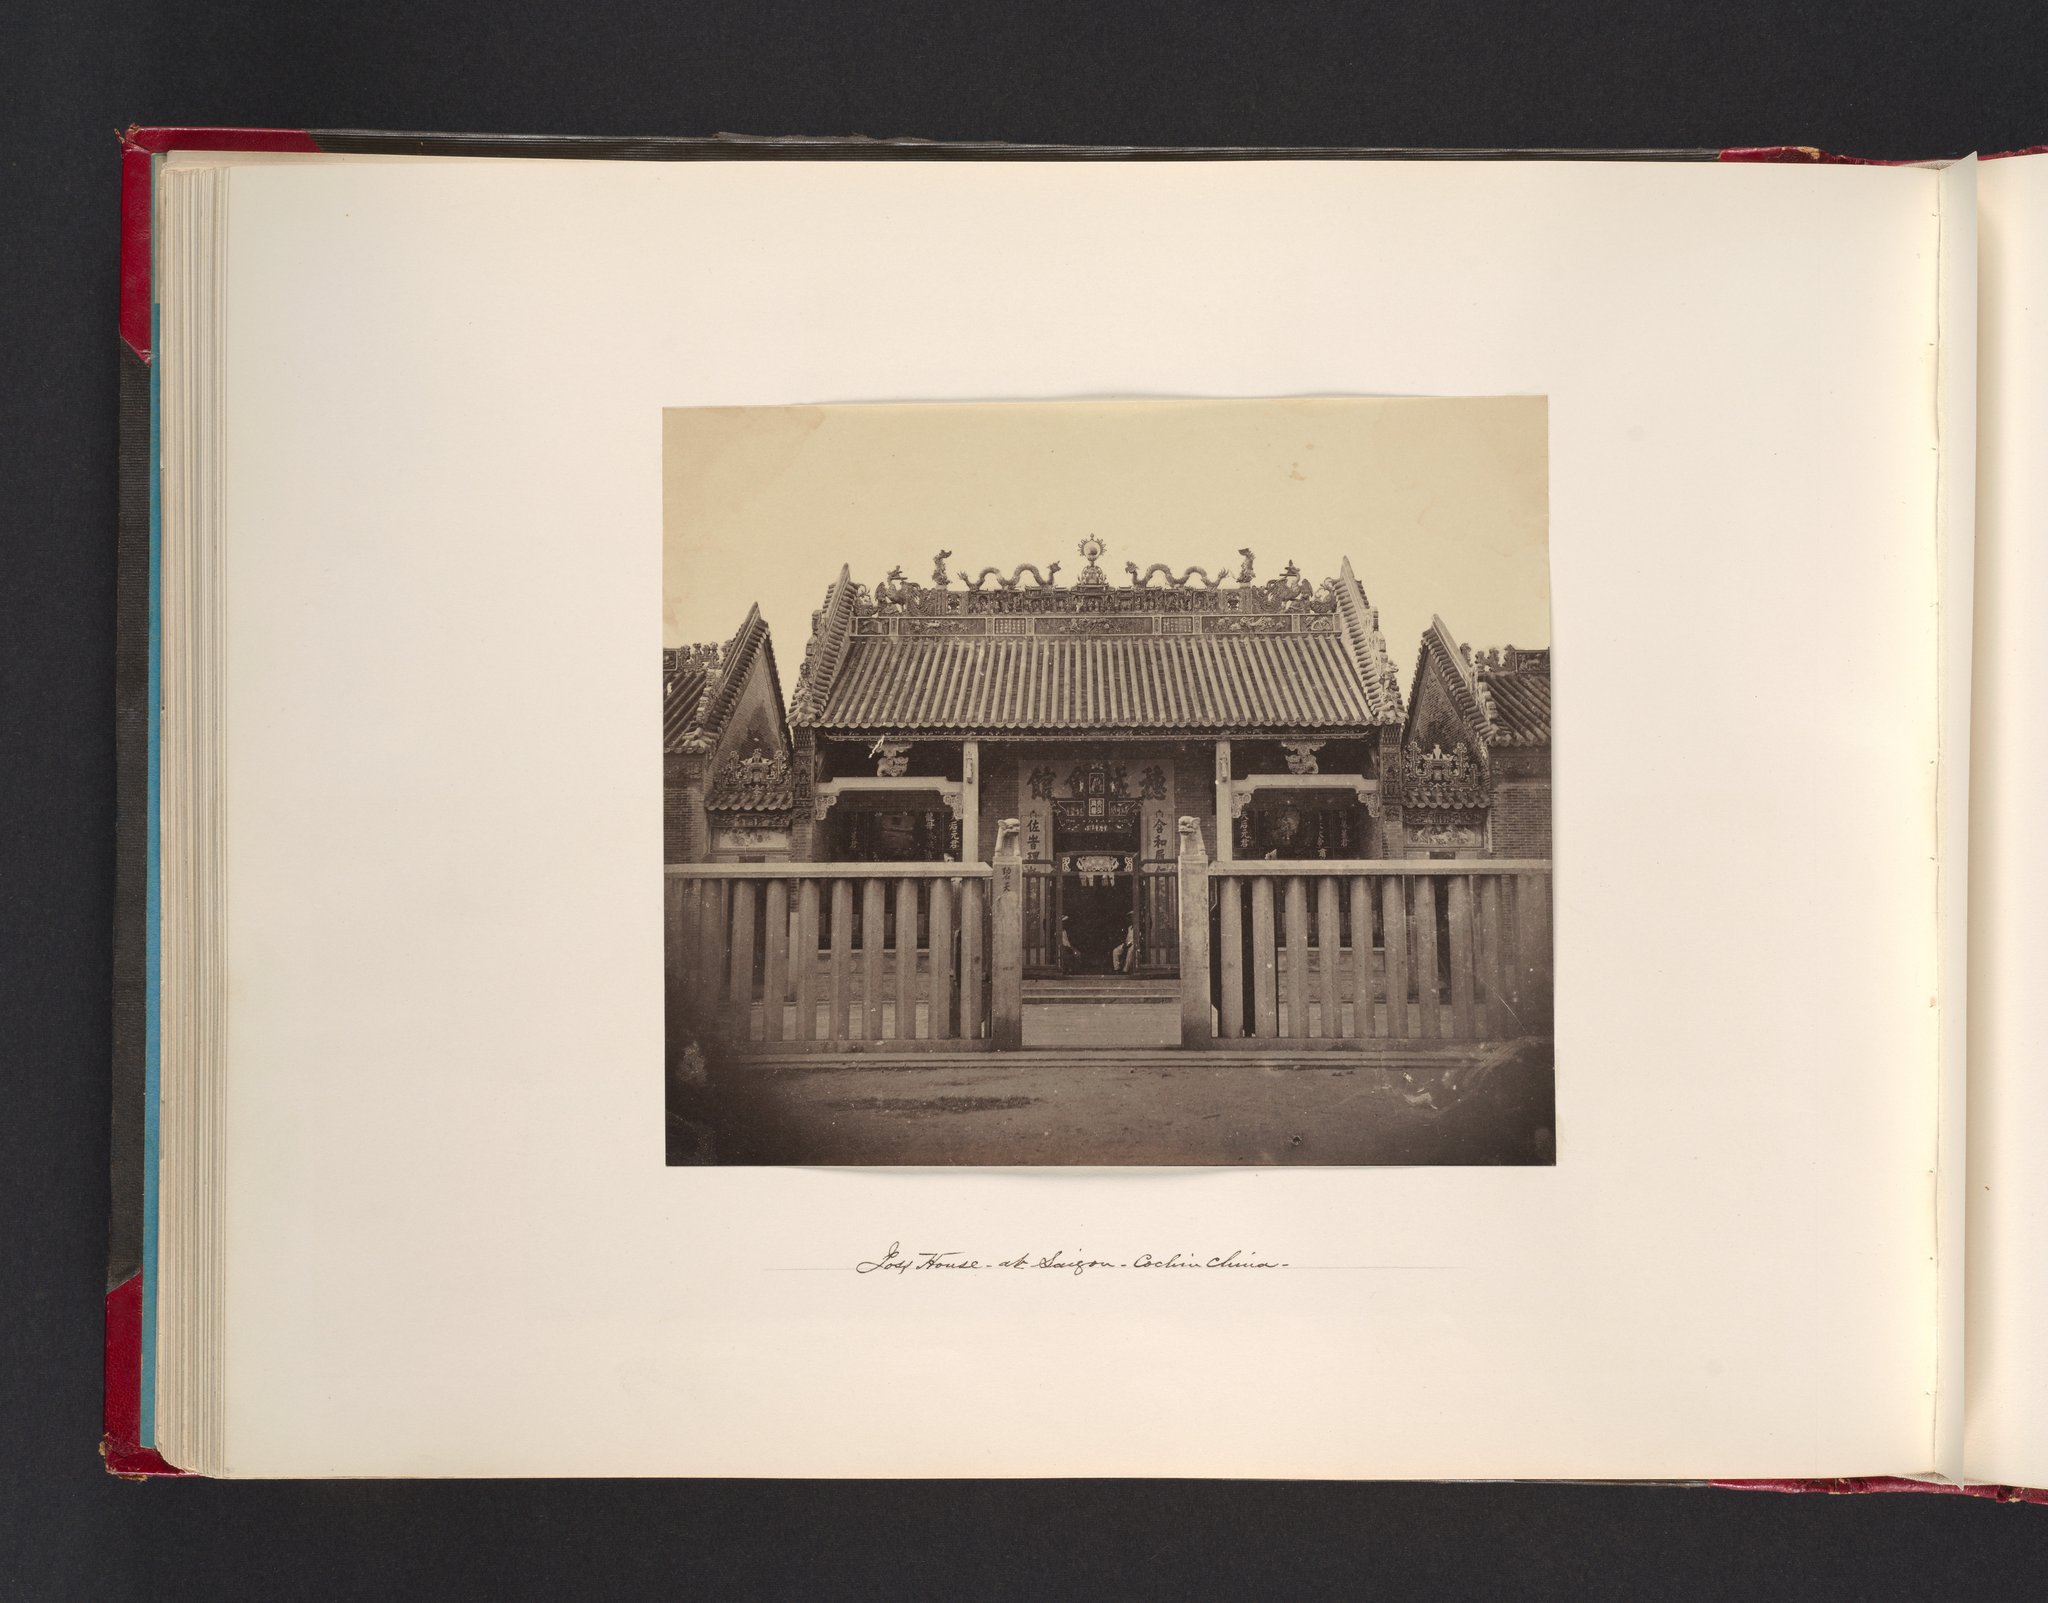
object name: photograph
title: House in Saigon, Cochin China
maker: john thomson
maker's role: artist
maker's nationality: british, scottish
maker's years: 1837-1921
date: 1865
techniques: albumen silver print, glass negative